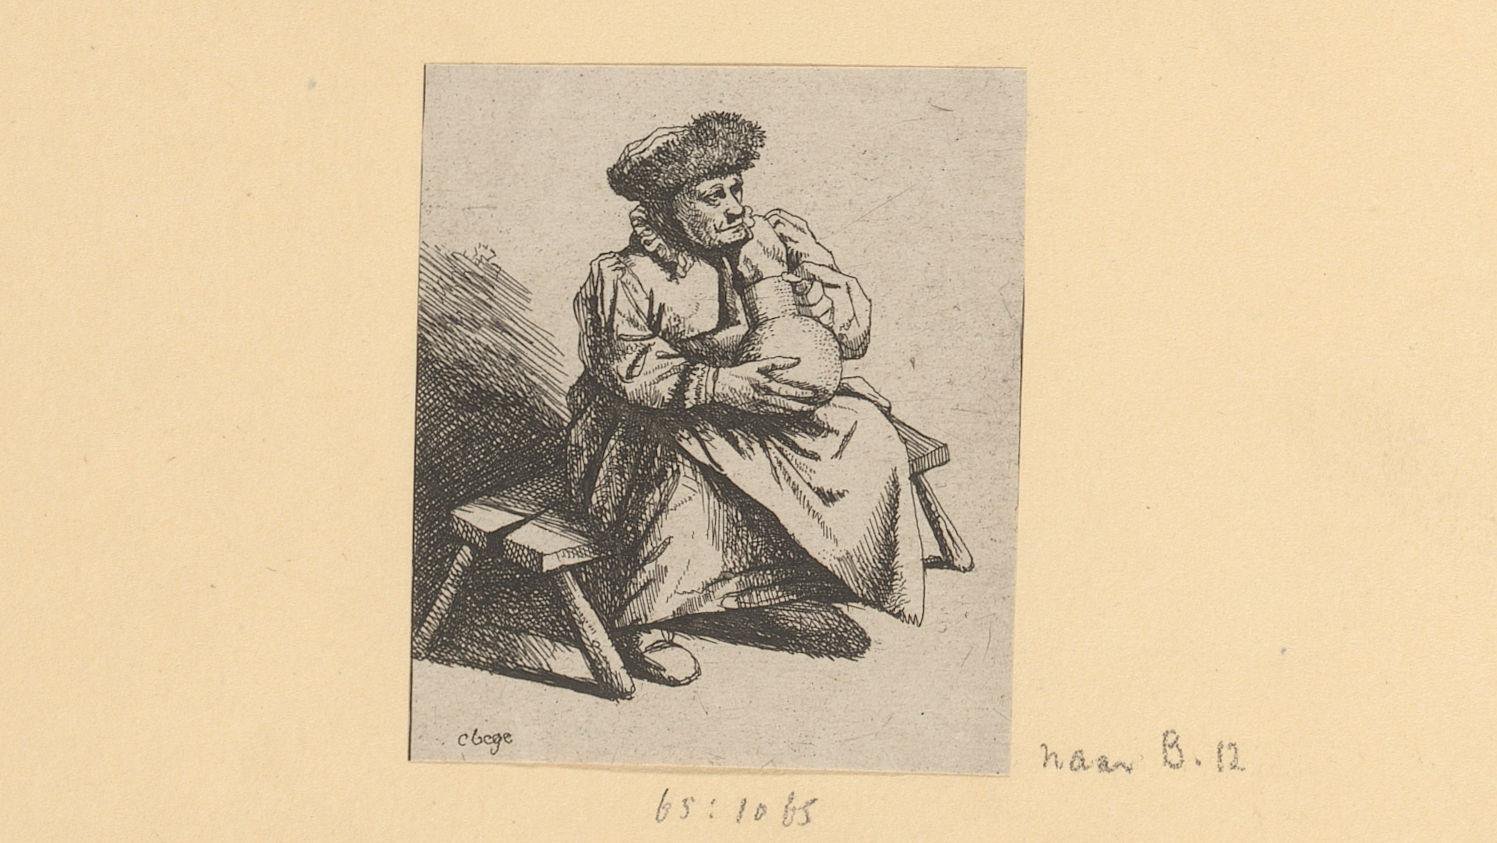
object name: print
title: Vrouw zittend met een kruik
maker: Anonymous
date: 1641-1664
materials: paper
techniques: etching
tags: old woman, container of ceramics: jar, jug, pot, vase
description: Prent maakt mogelijk deel uit van een serie van 200 prenten. Deze serie is onder de titel 'A Collection of two hundred original etchings' voor het eerst uitgegeven door J.M. Greery in 1816.